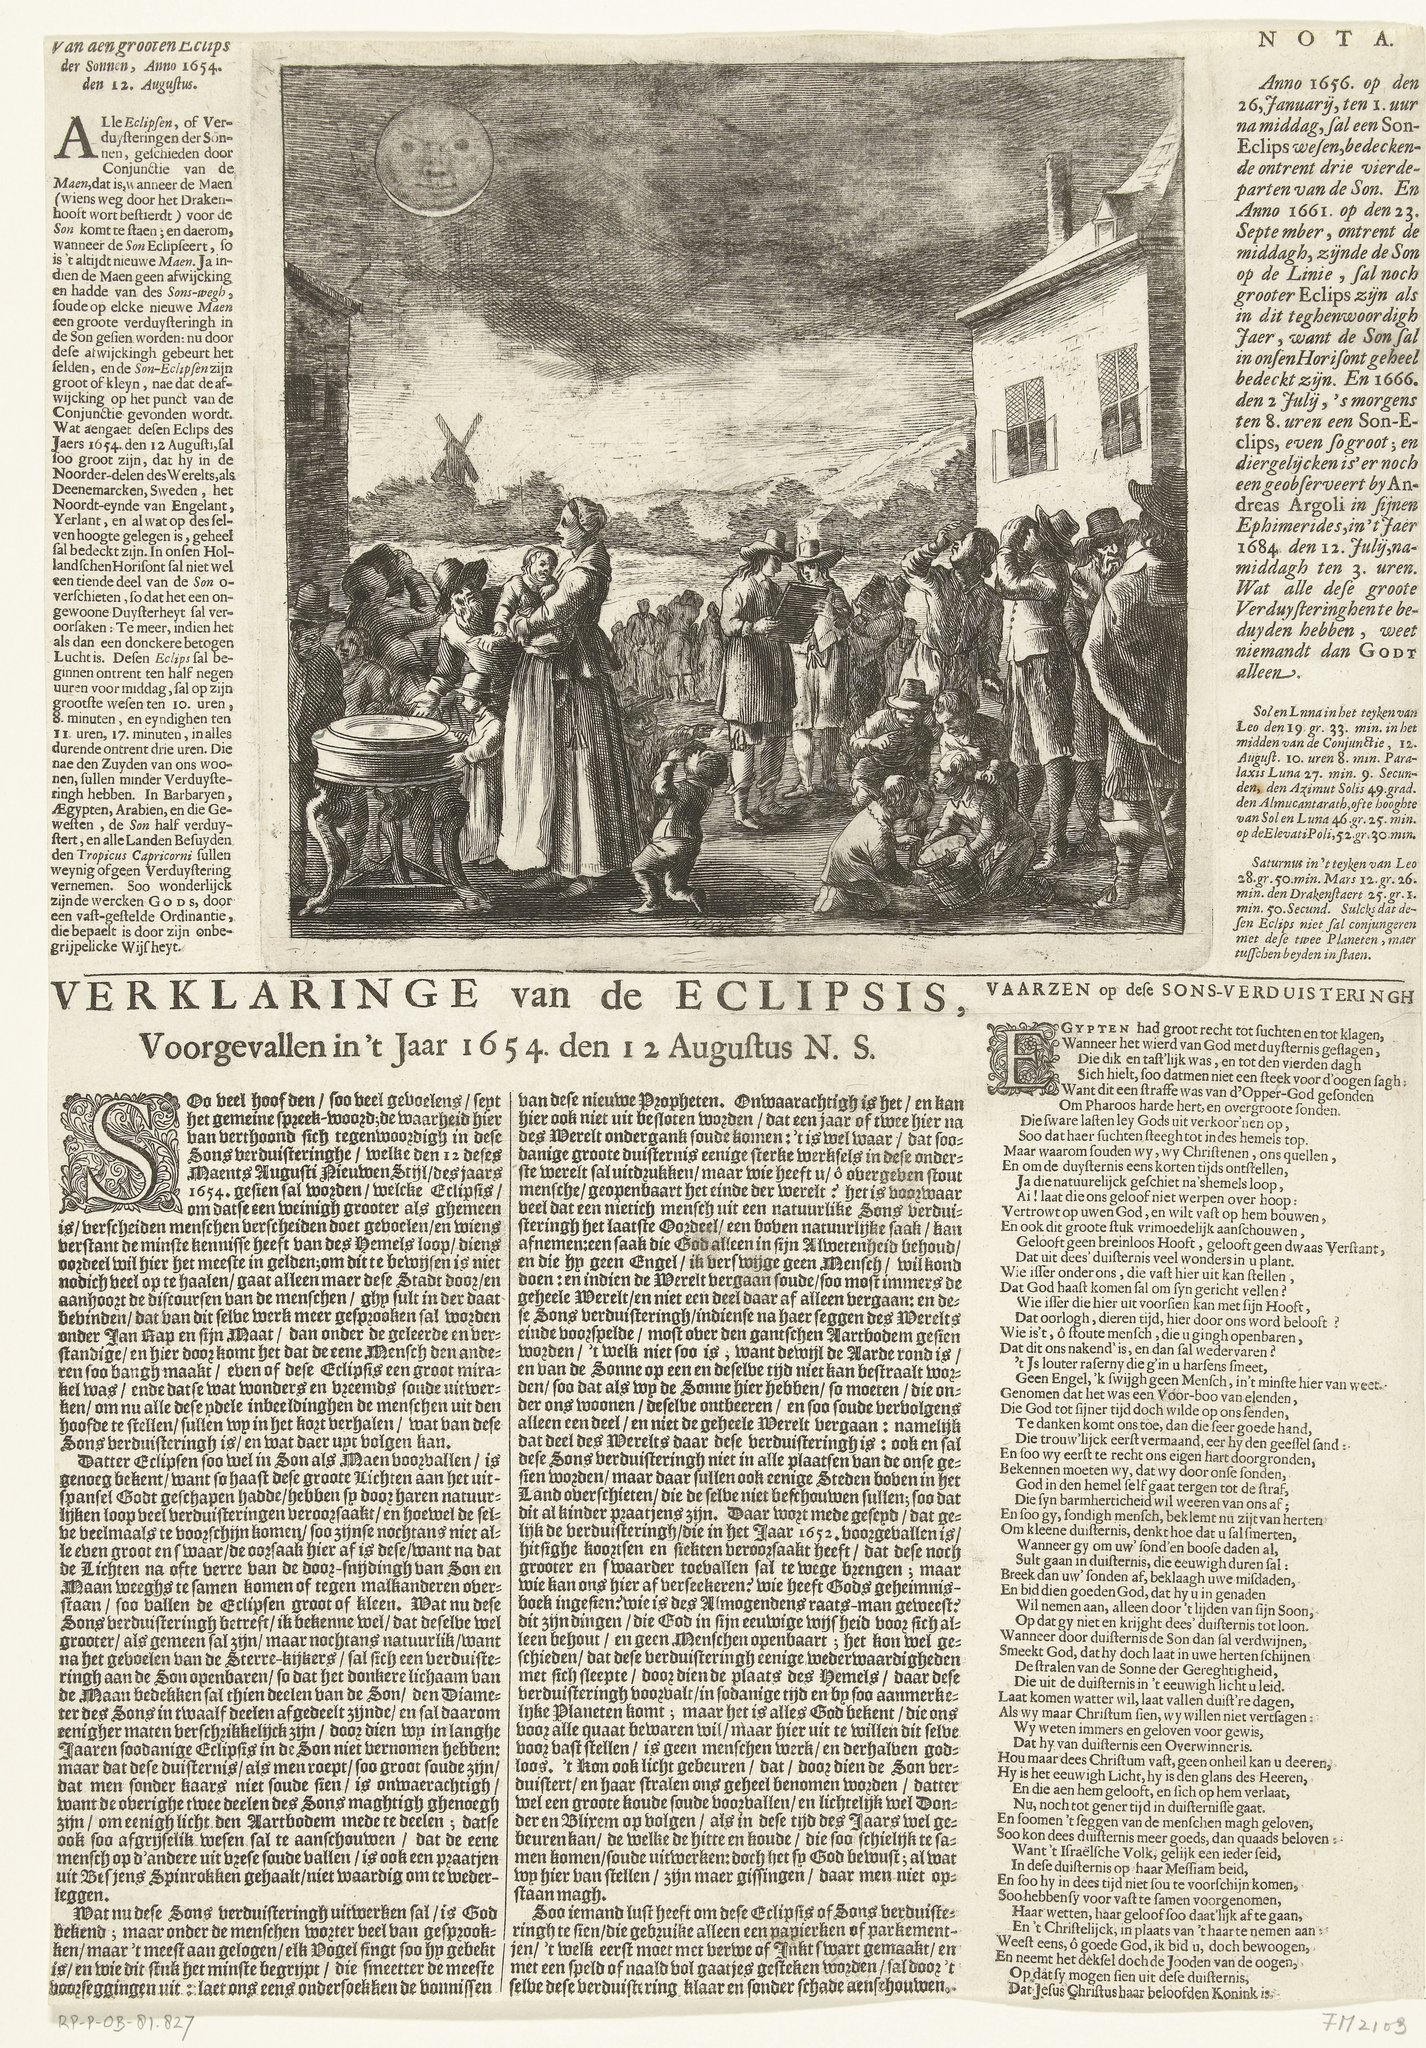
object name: print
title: Verklaringe van de Eclipsis, Voorgevallen in 't Jaar 1654. den 12 Augustus N.S.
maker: Anonymous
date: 1654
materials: paper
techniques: engraving, etching, letterpress printing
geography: northern netherlands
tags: solar eclipse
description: De zonsverduistering van 12 augustus 1654, waargenomen op allerlei verschillende manieren door een groep mensen buitenshuis. Naast en onder de plaat een beschrijving van de het fenomeen, een gedicht en een lijst van de komende zonsverduisteringen in de jaren 1656-1684.